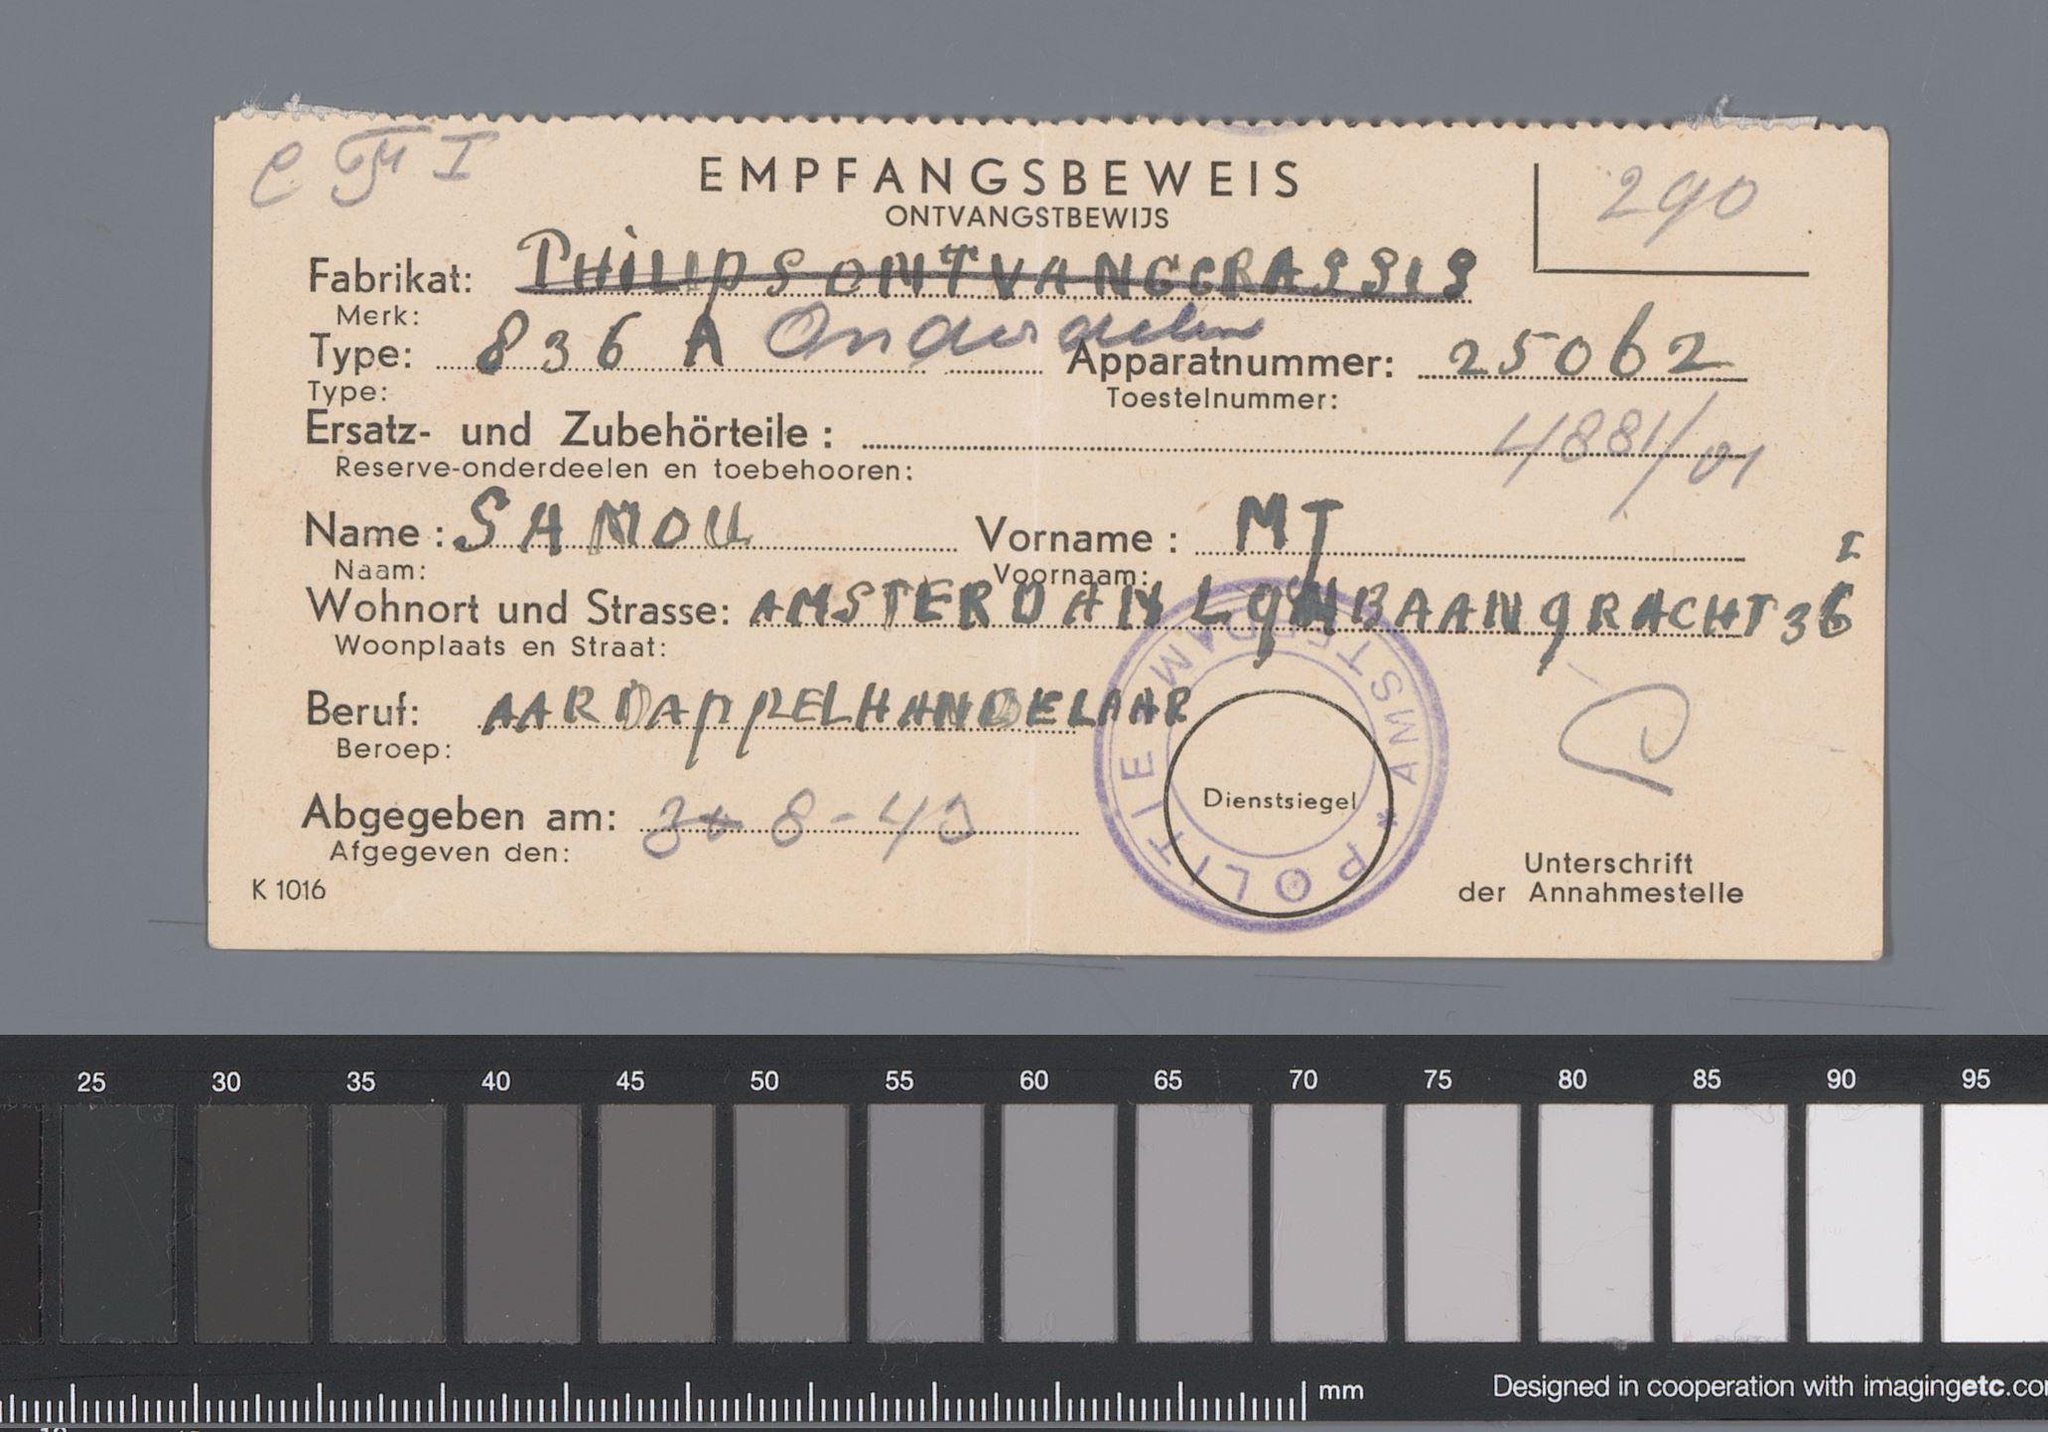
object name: document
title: Ontvangstbewijs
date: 1943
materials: ink, paper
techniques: printing, writing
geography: amsterdam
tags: netherlands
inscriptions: date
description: Een ontvangstbewijs betreffende onderdelen van een Philips-radio die moesten worden ingeleverd. Opschrift; o.: stempel: 'Politie / Amsterdam. Gesigneerd en gedateerd.